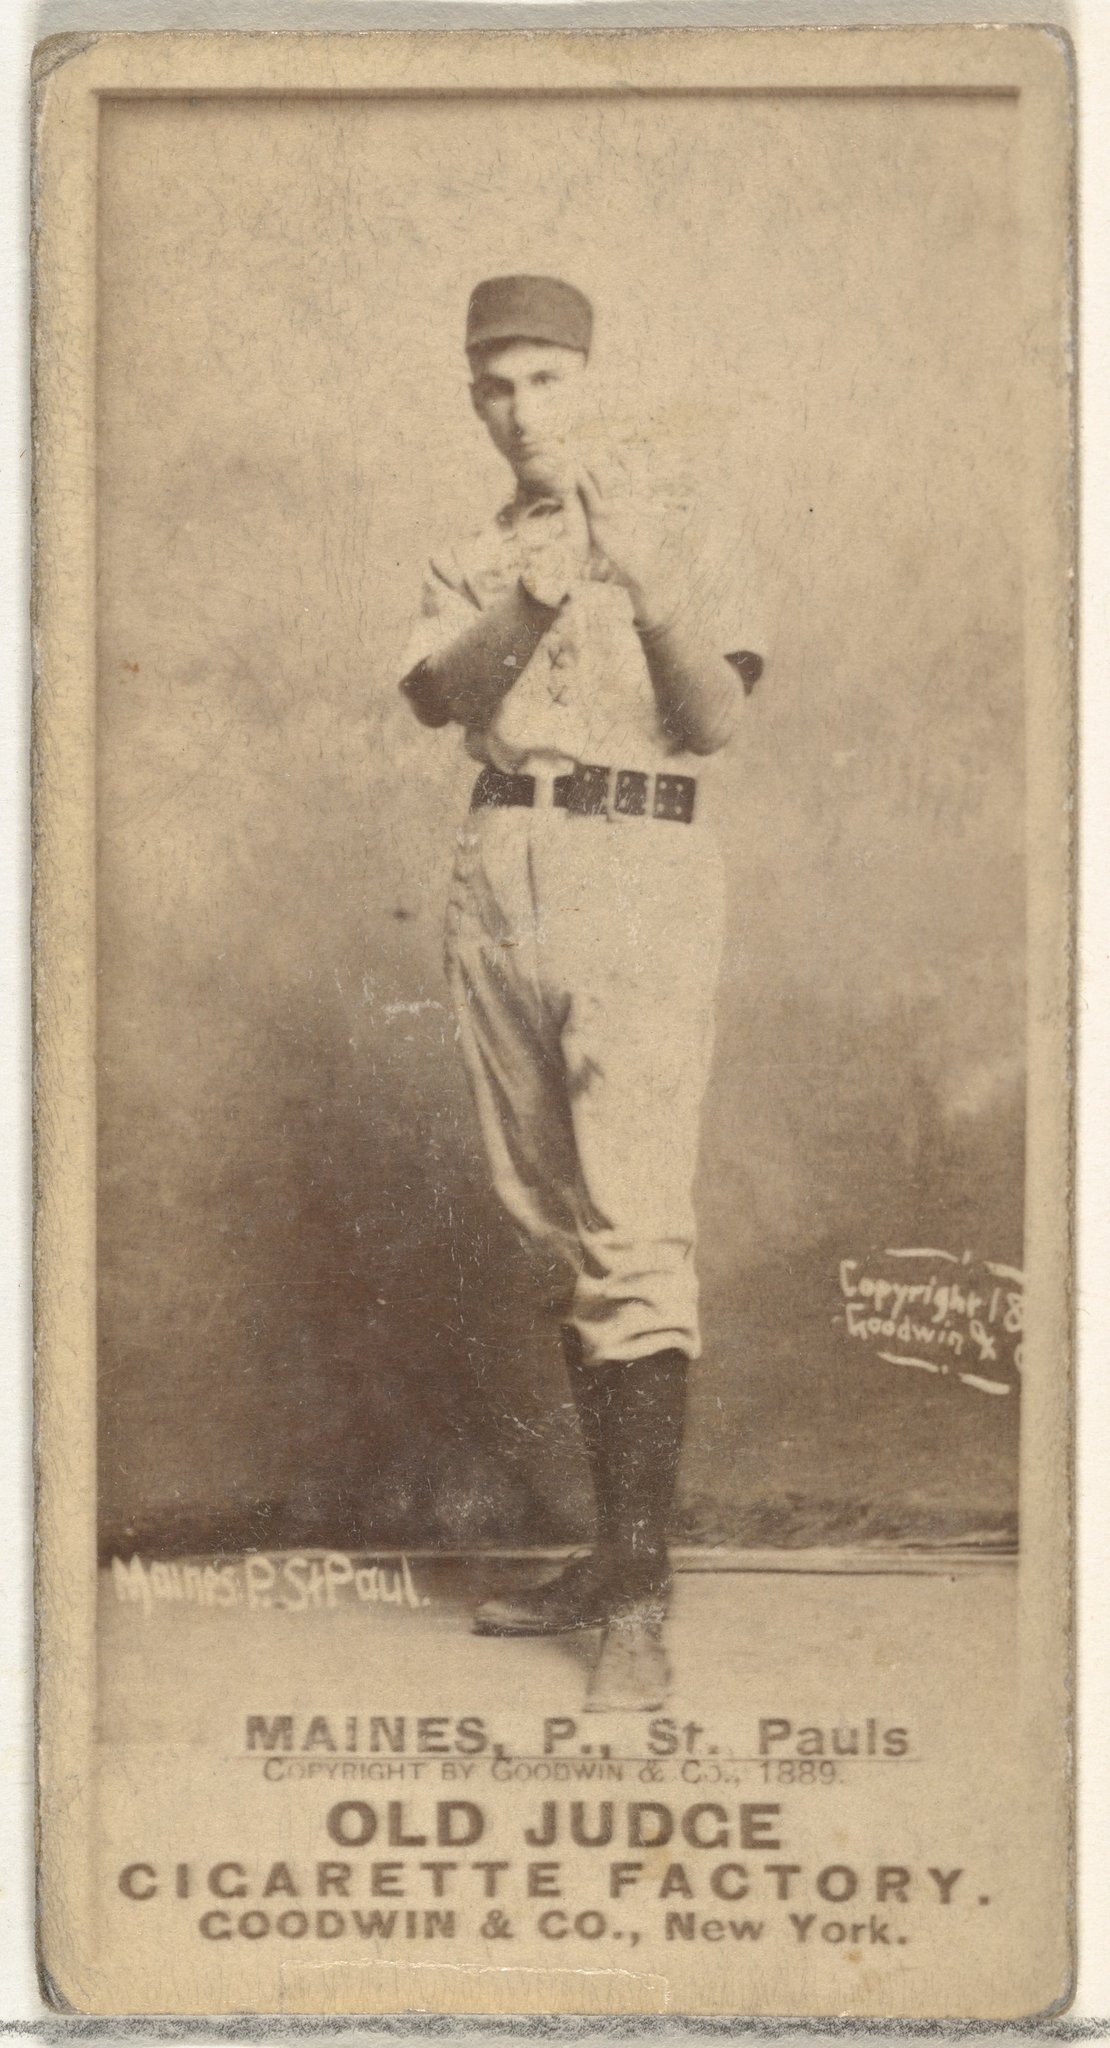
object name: baseball card, photograph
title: Willard Eben Mains, Pitcher, St. Paul Apostles, from the Old Judge series (N172) for Old Judge Cigarettes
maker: goodwin & company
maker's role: publisher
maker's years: 1850-1950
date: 1889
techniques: albumen silver print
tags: men,portraits,baseball,athletes